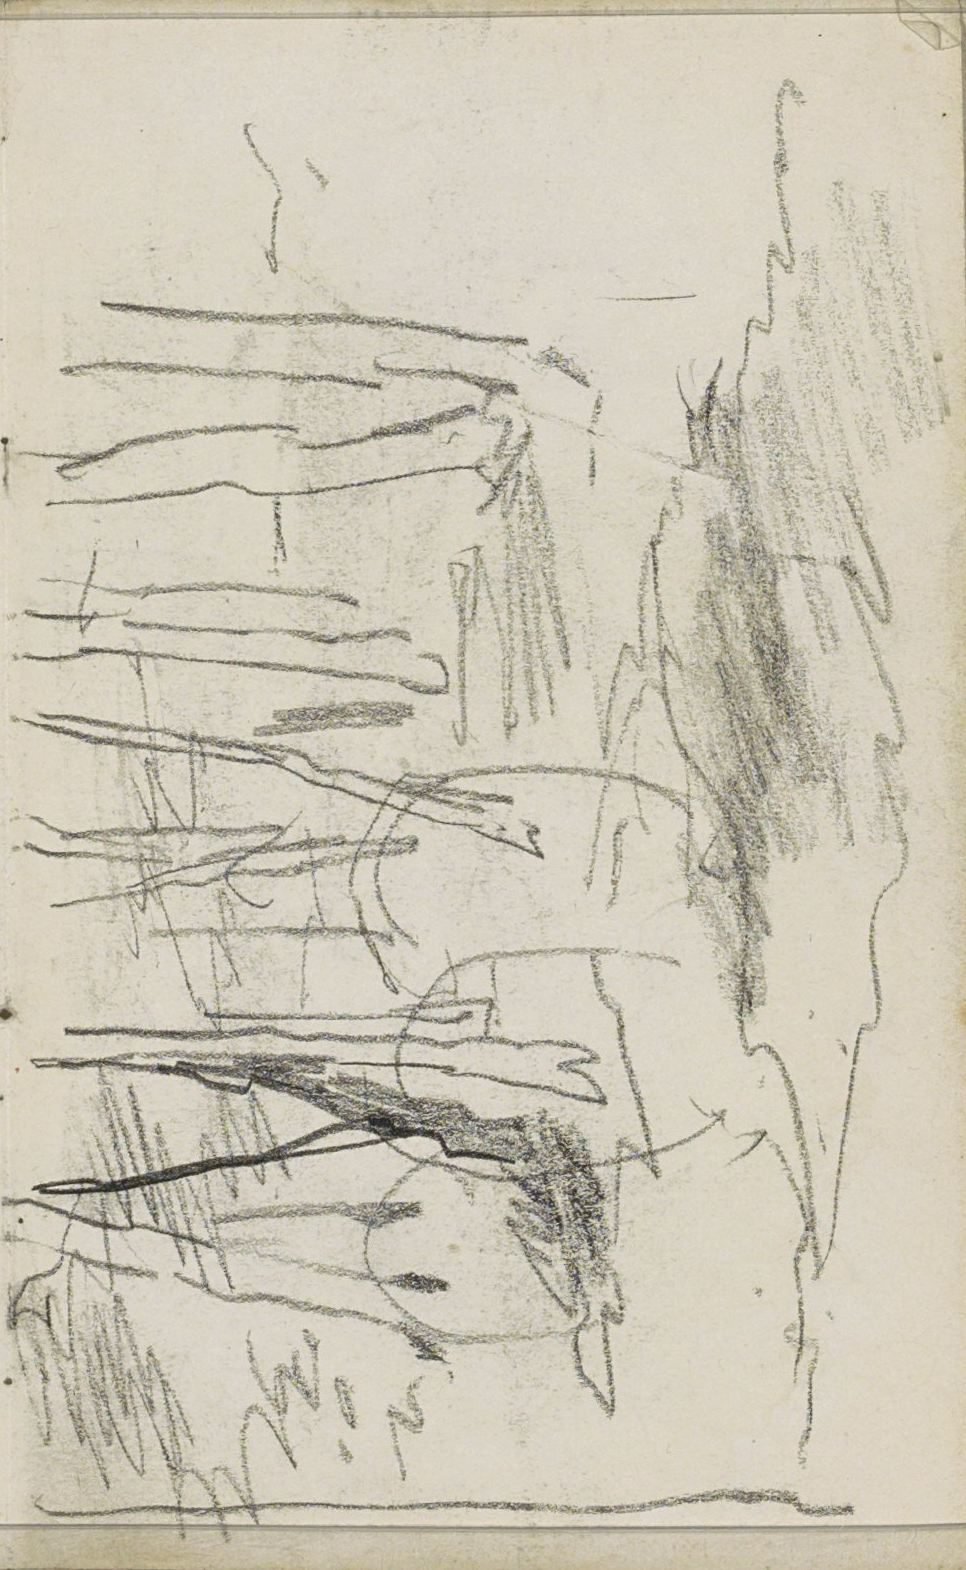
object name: sketchbook leaf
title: Studie, vermoedelijk een landschap met bomen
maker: anton mauve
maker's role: draughtsman, painter, print maker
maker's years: 1838-1888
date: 1848-1888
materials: chalk, paper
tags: landscapes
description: Blad 6 recto uit een schetsboek met 53 bladen.